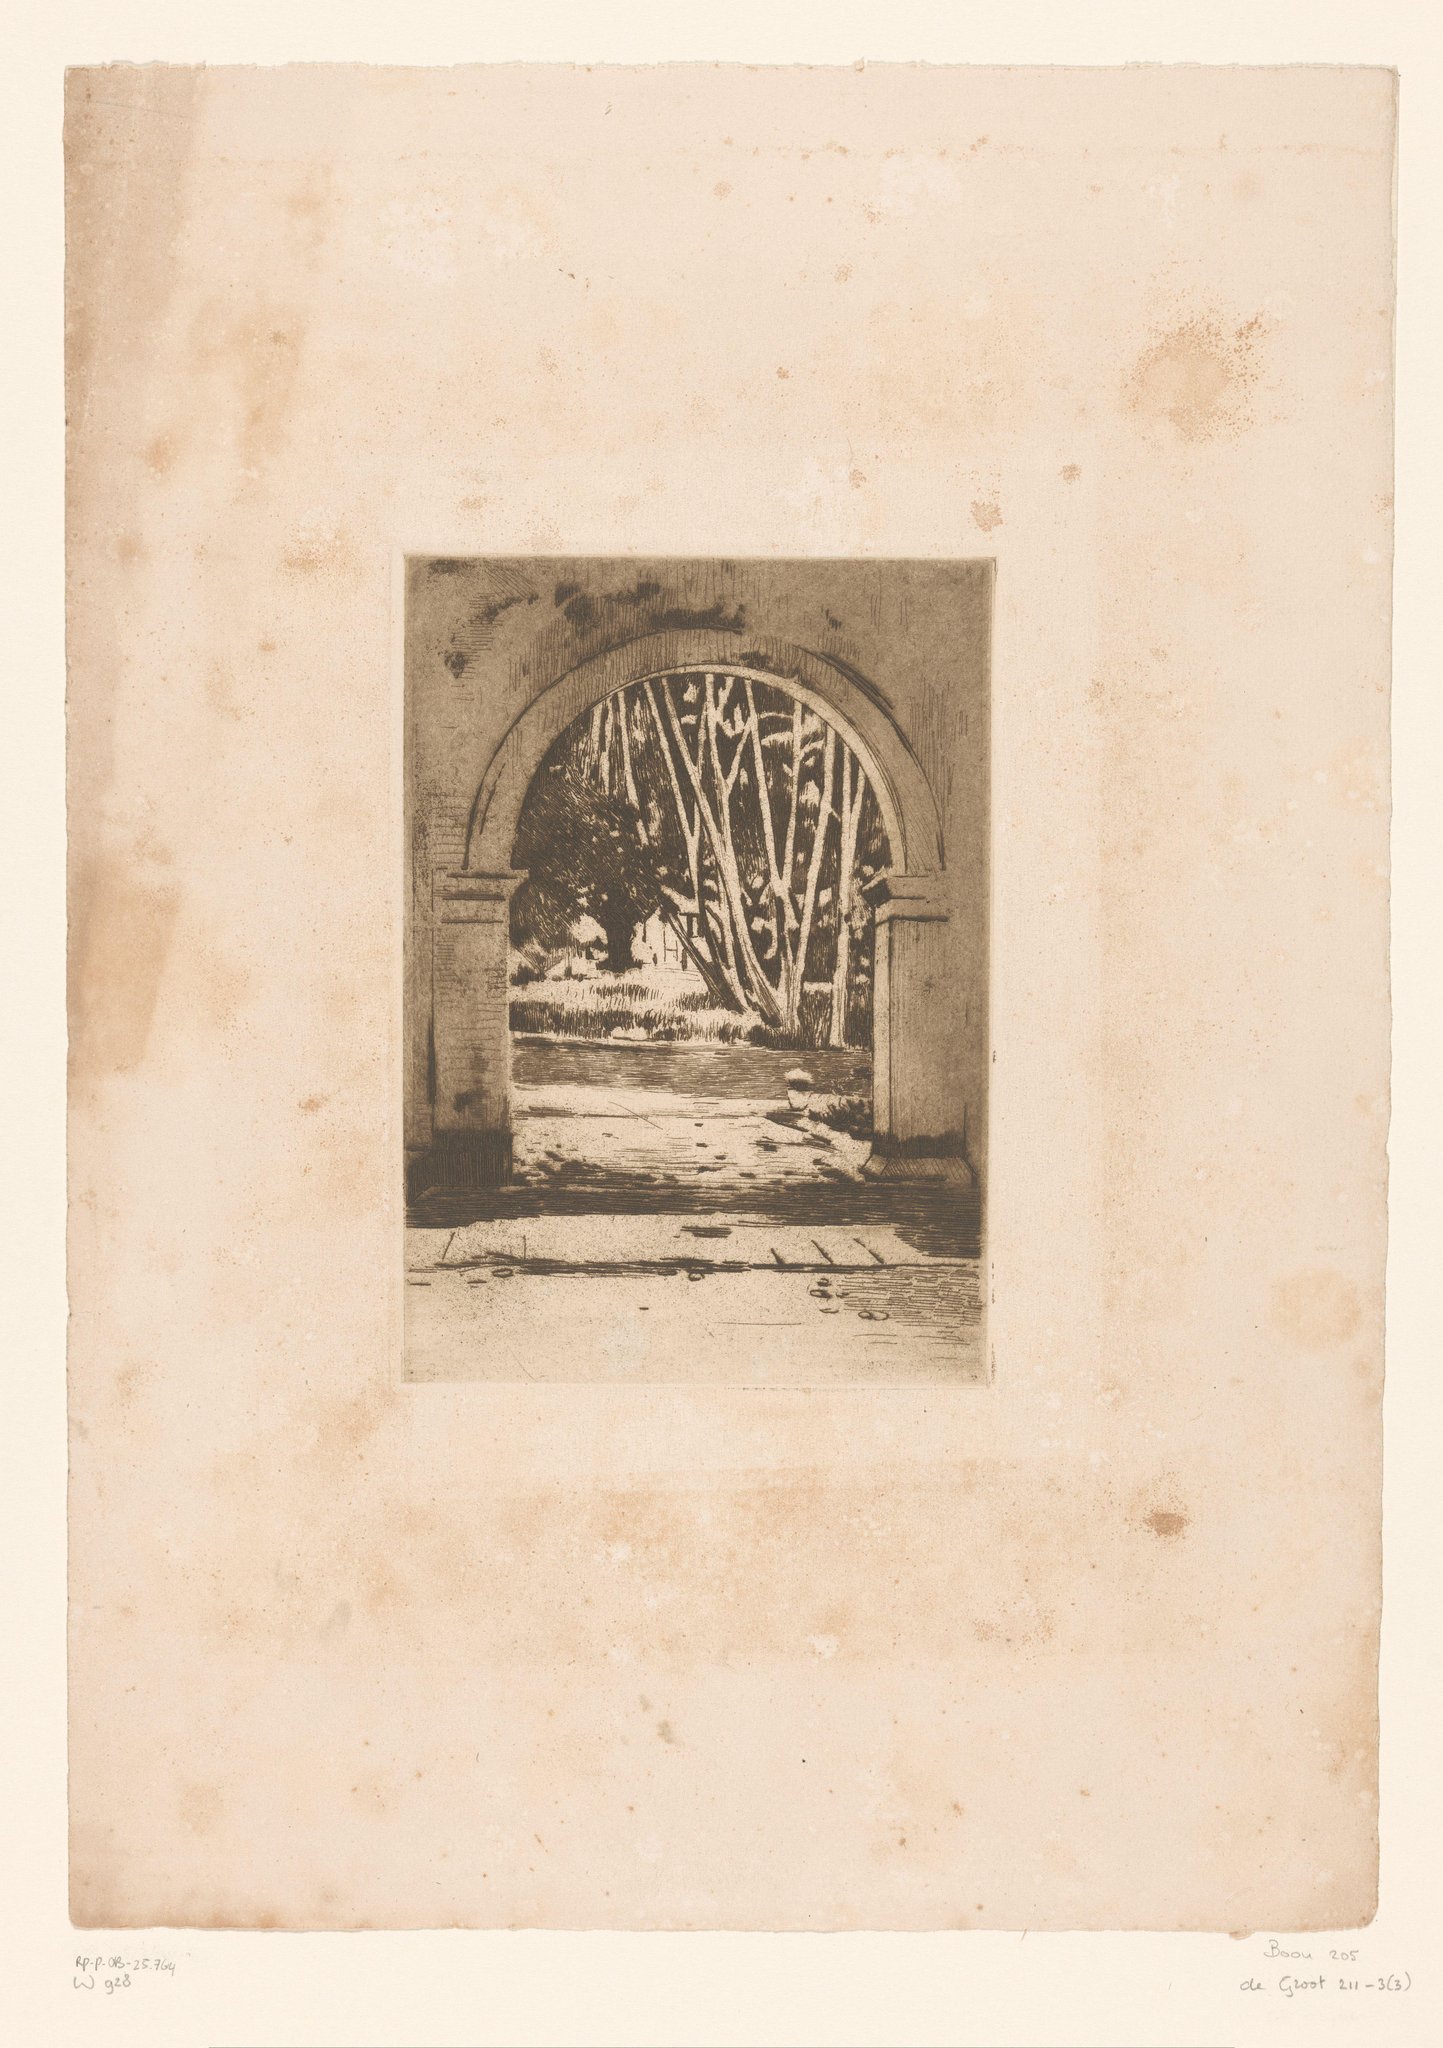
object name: print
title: Poort van Hotel Bellevue in Buitenzorg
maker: willem witsen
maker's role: draughtsman, painter, print maker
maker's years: 1860-1923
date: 1921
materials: paper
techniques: aquatint, etching, intaglio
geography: amsterdam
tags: plantation, arch, archivolt ~ architecture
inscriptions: watermark